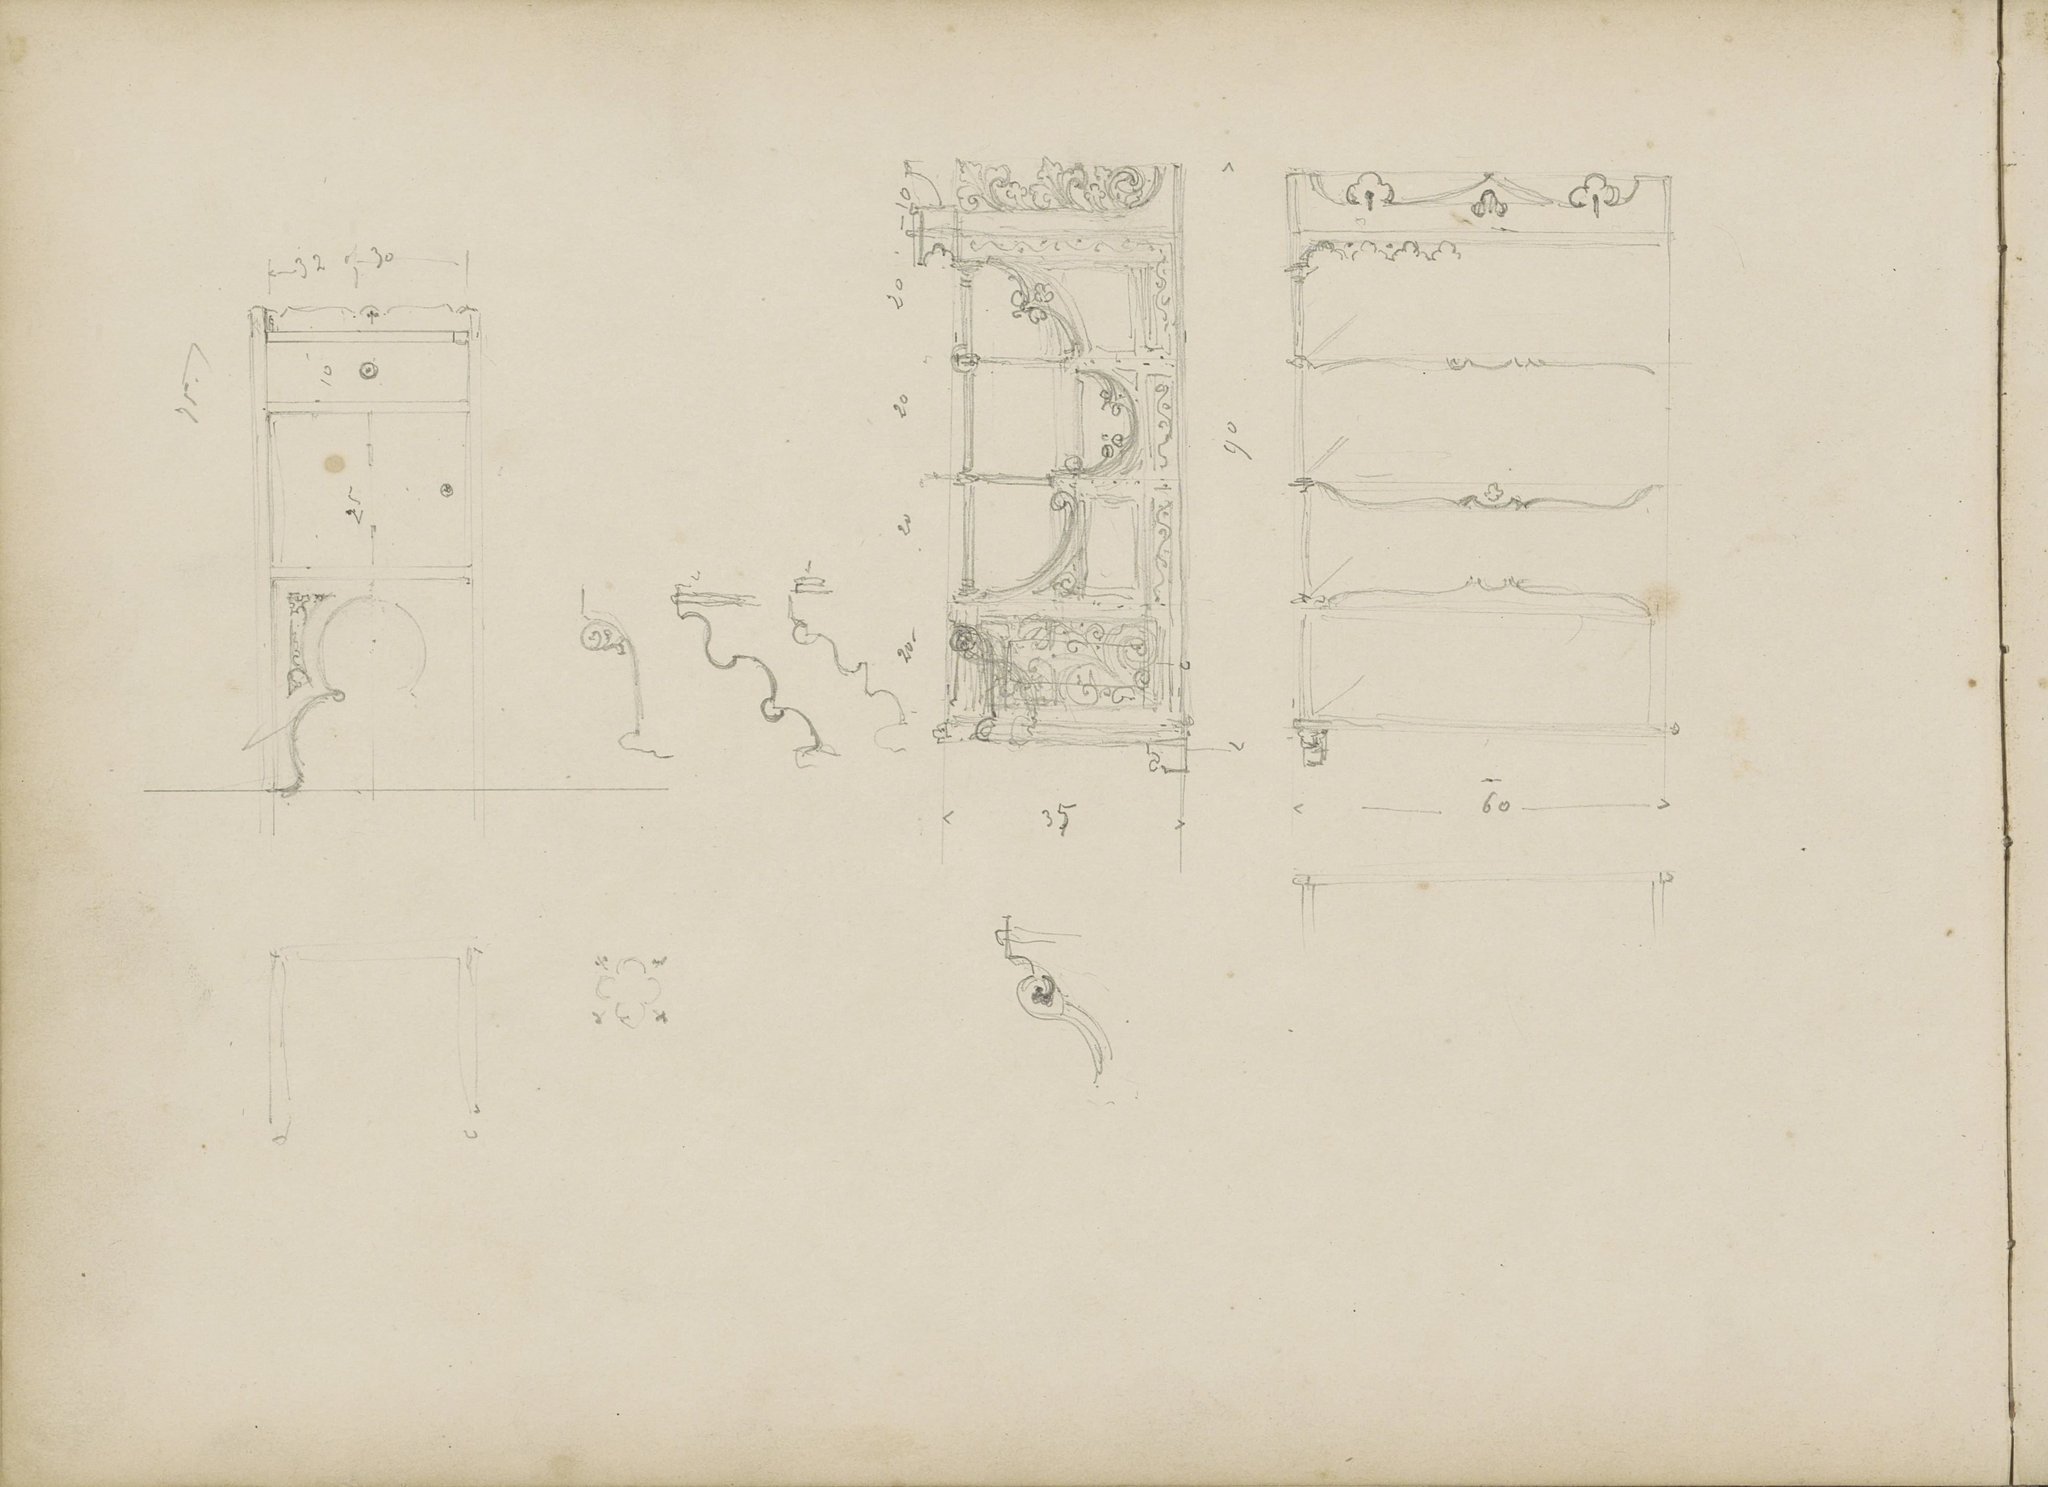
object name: sketchbook leaf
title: Nachtkastjes en een kast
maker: pierre joseph hubert cuypers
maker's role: draughtsman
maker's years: 1827-1921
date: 1857-1859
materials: paper, pencil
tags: furniture for storage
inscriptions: annotation: ‘[...]’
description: Blad 57 verso uit een schetsboek met 77 bladen.